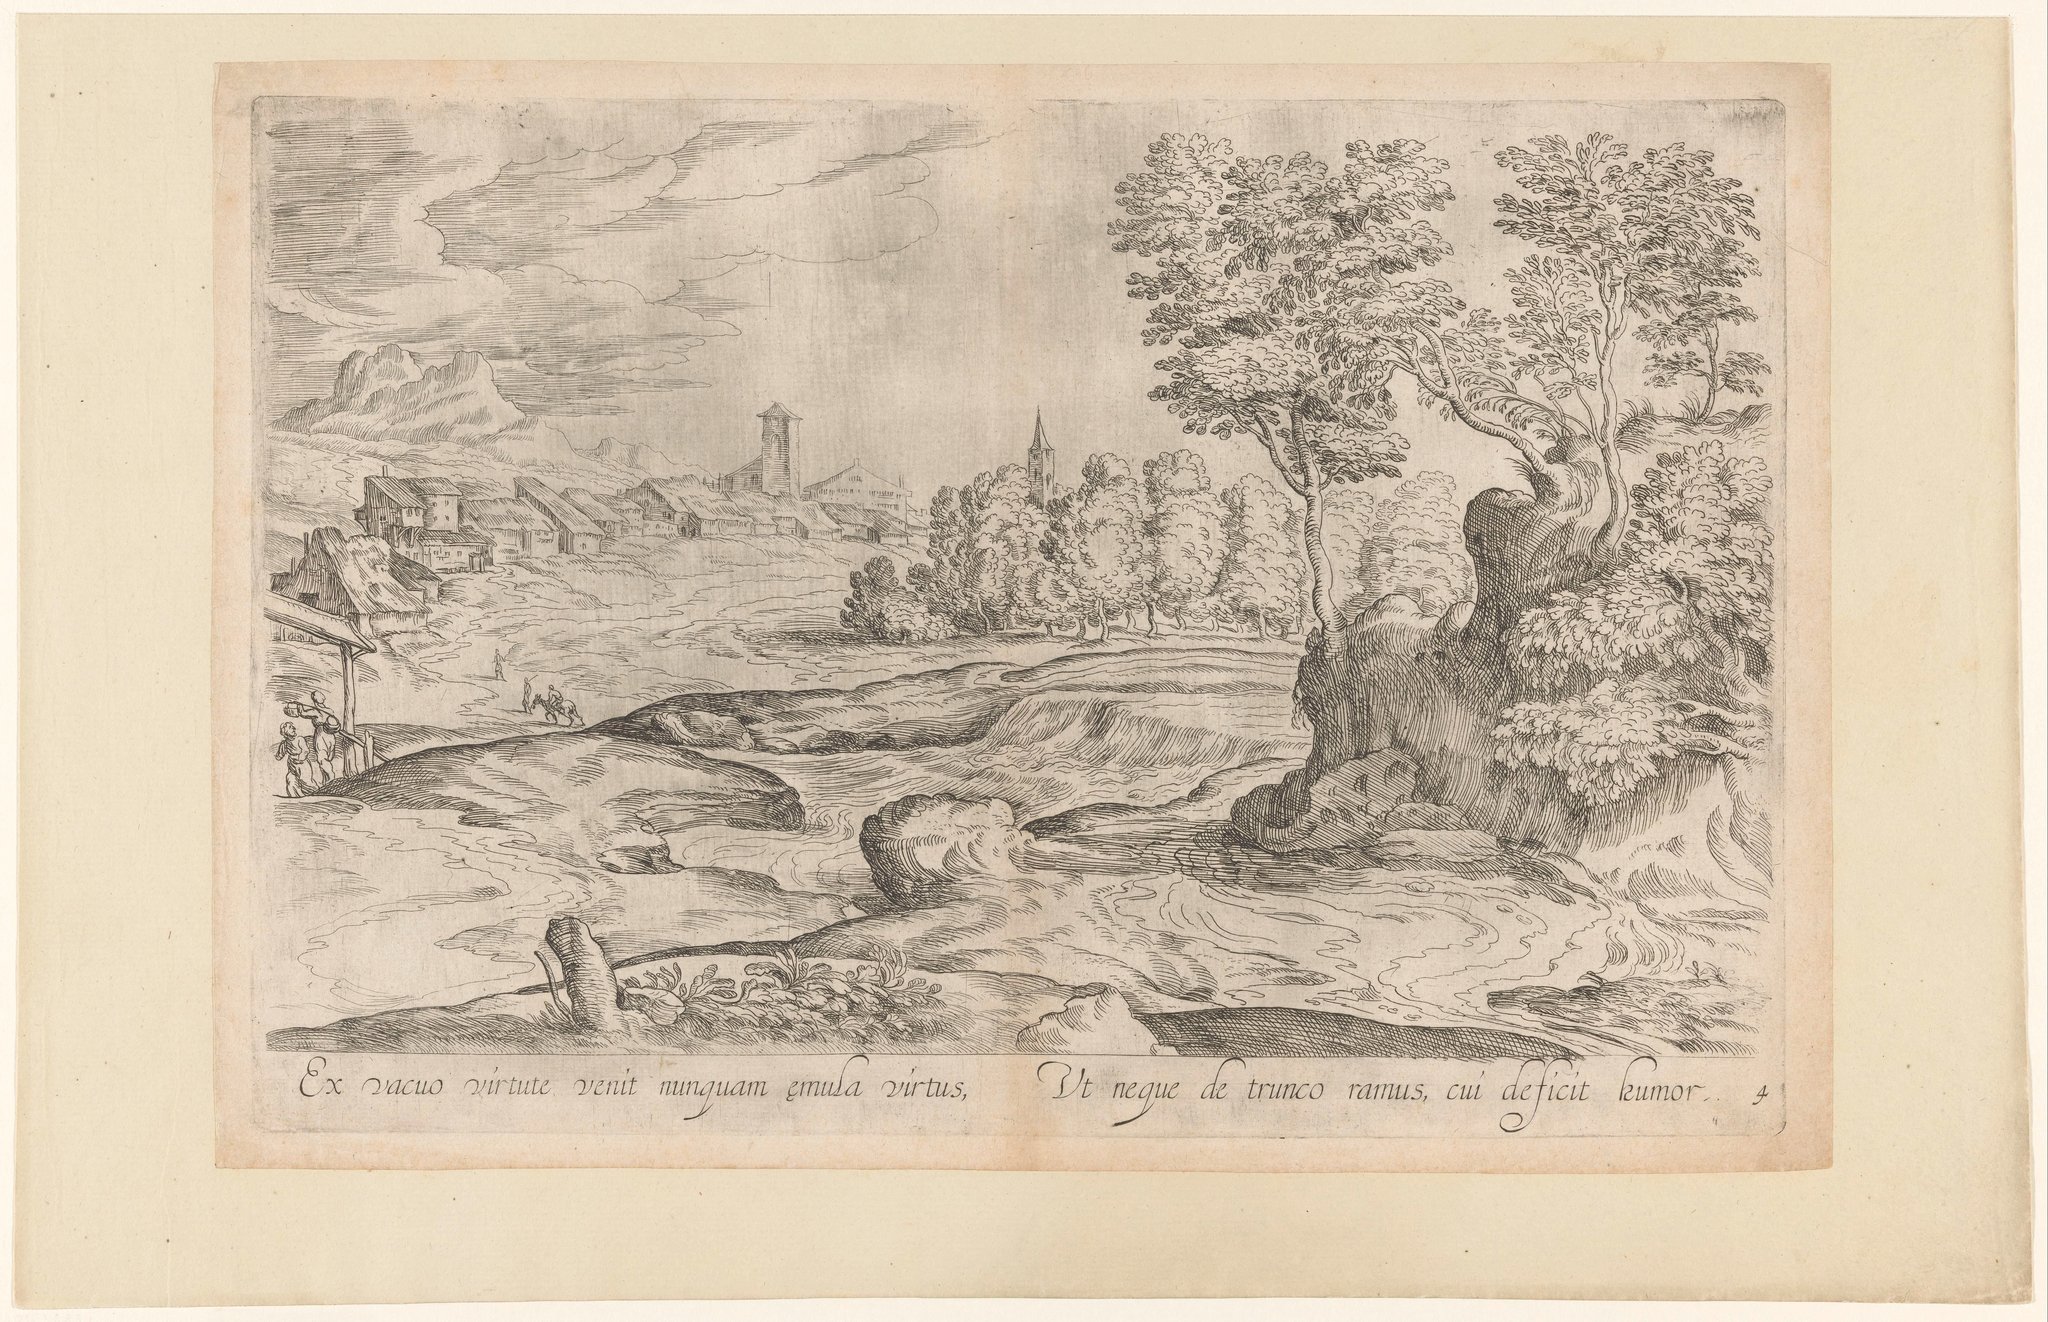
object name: print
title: Rivierlandschap met dorp op achtergrond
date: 1600-1699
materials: paper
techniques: etching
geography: italy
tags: landscapes, river, village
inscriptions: collector's mark: Lugt 2228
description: Deze prent maakt deel uit van een reeks van 24 landschapsprenten.